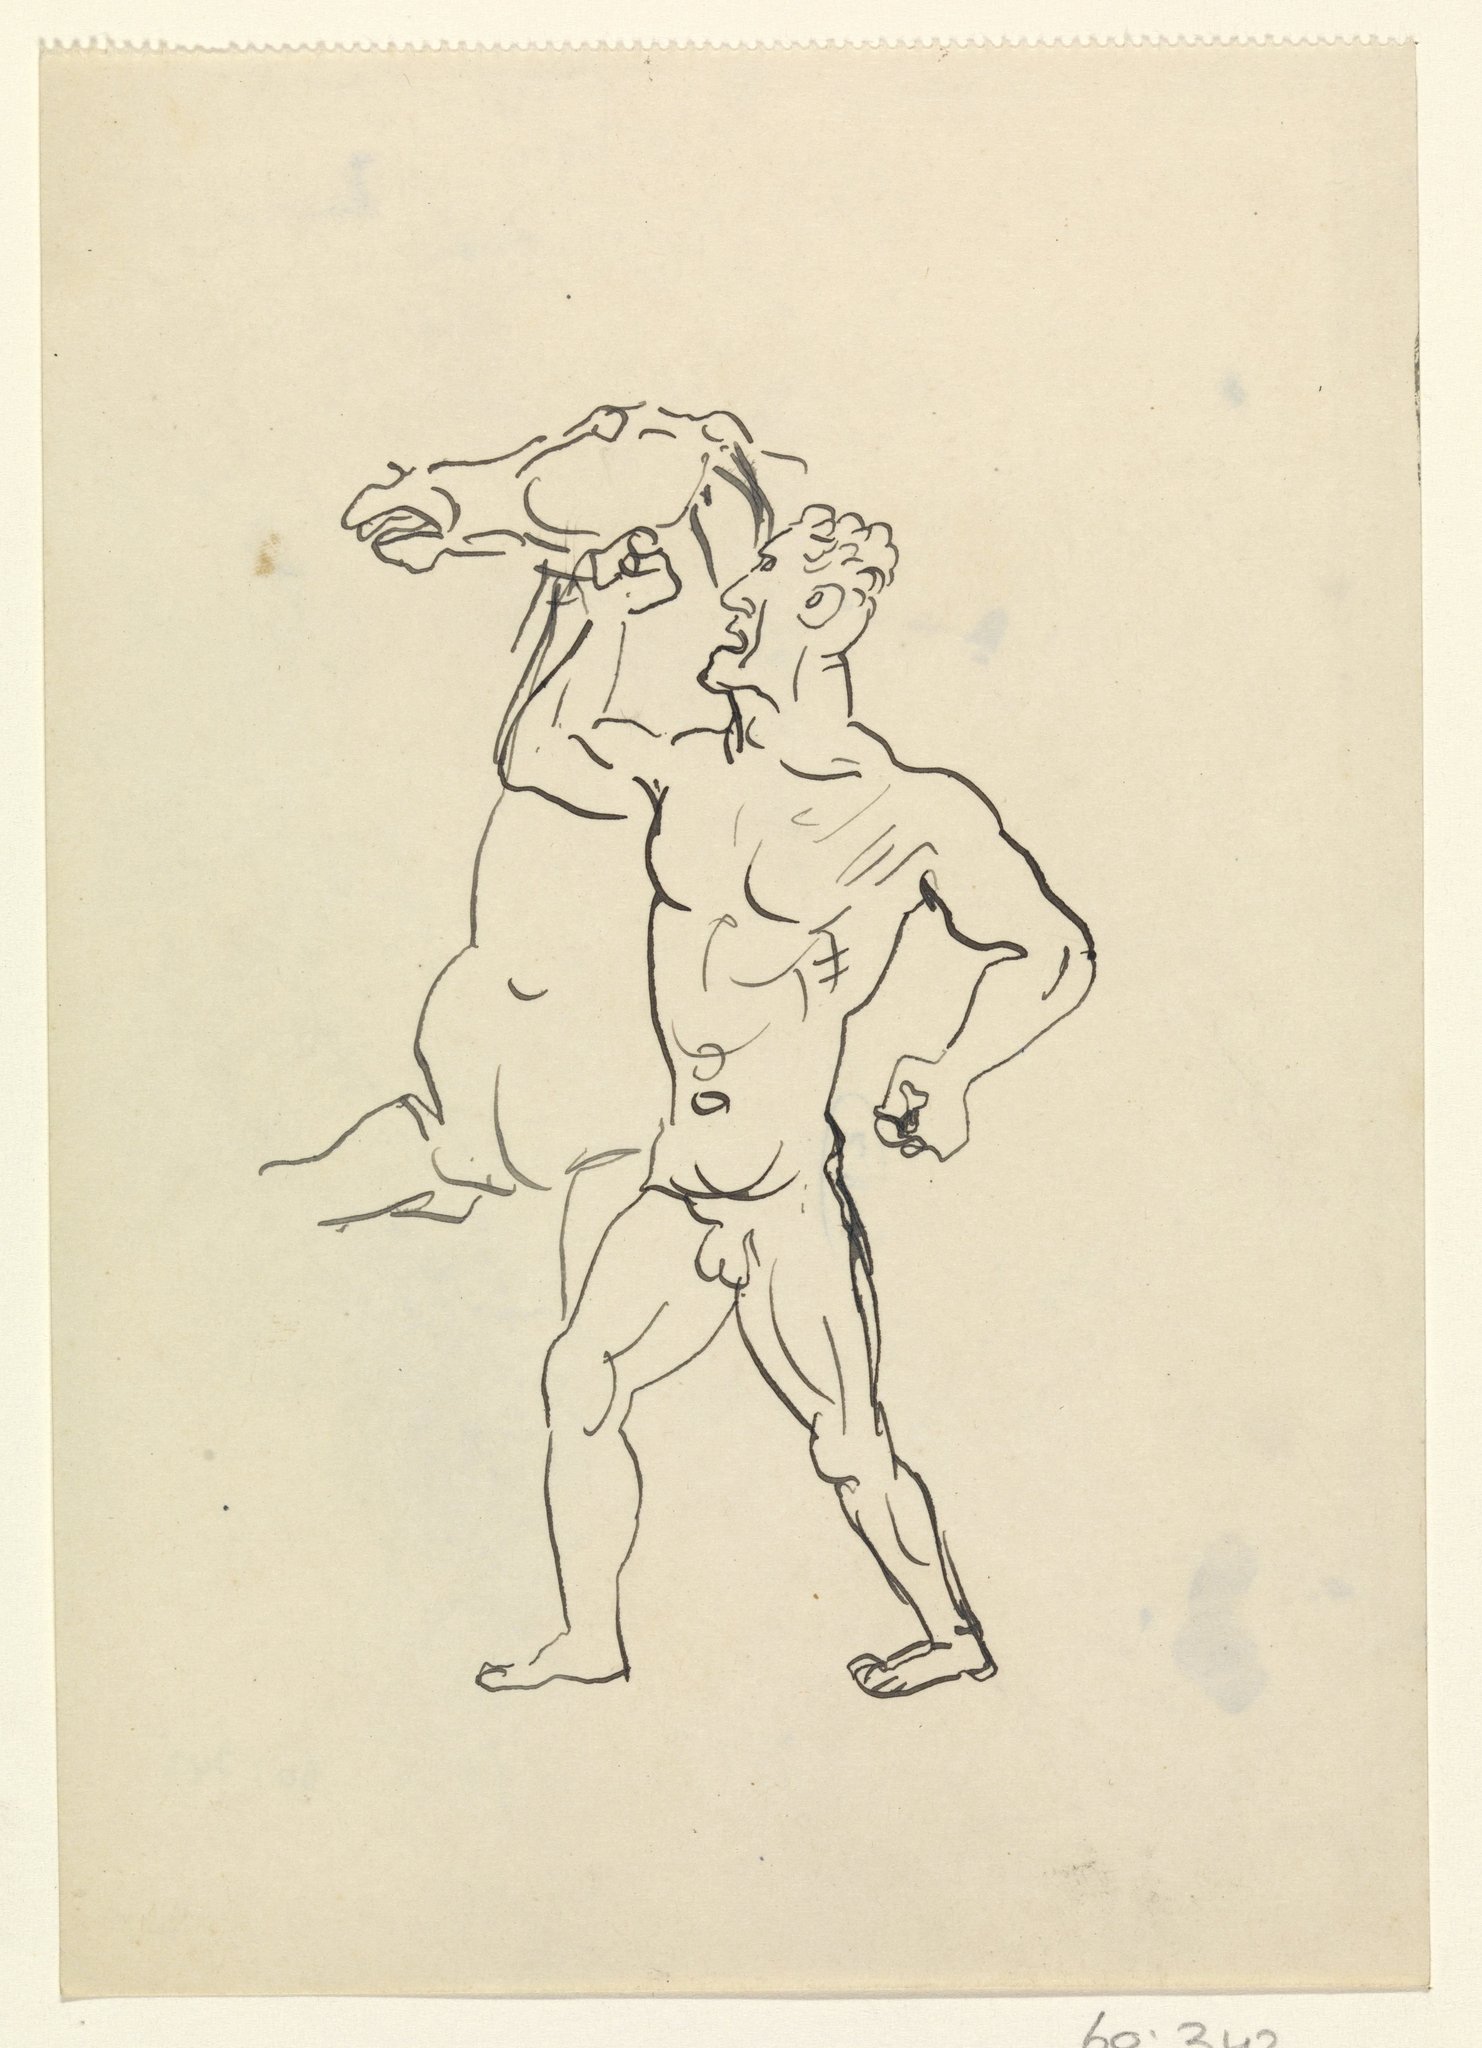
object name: drawing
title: Man houdt een paard in toom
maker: leo gestel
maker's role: draughtsman, print maker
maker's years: 1881-1941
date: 1891-1941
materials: ink, paper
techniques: pen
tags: horse, male sex; man